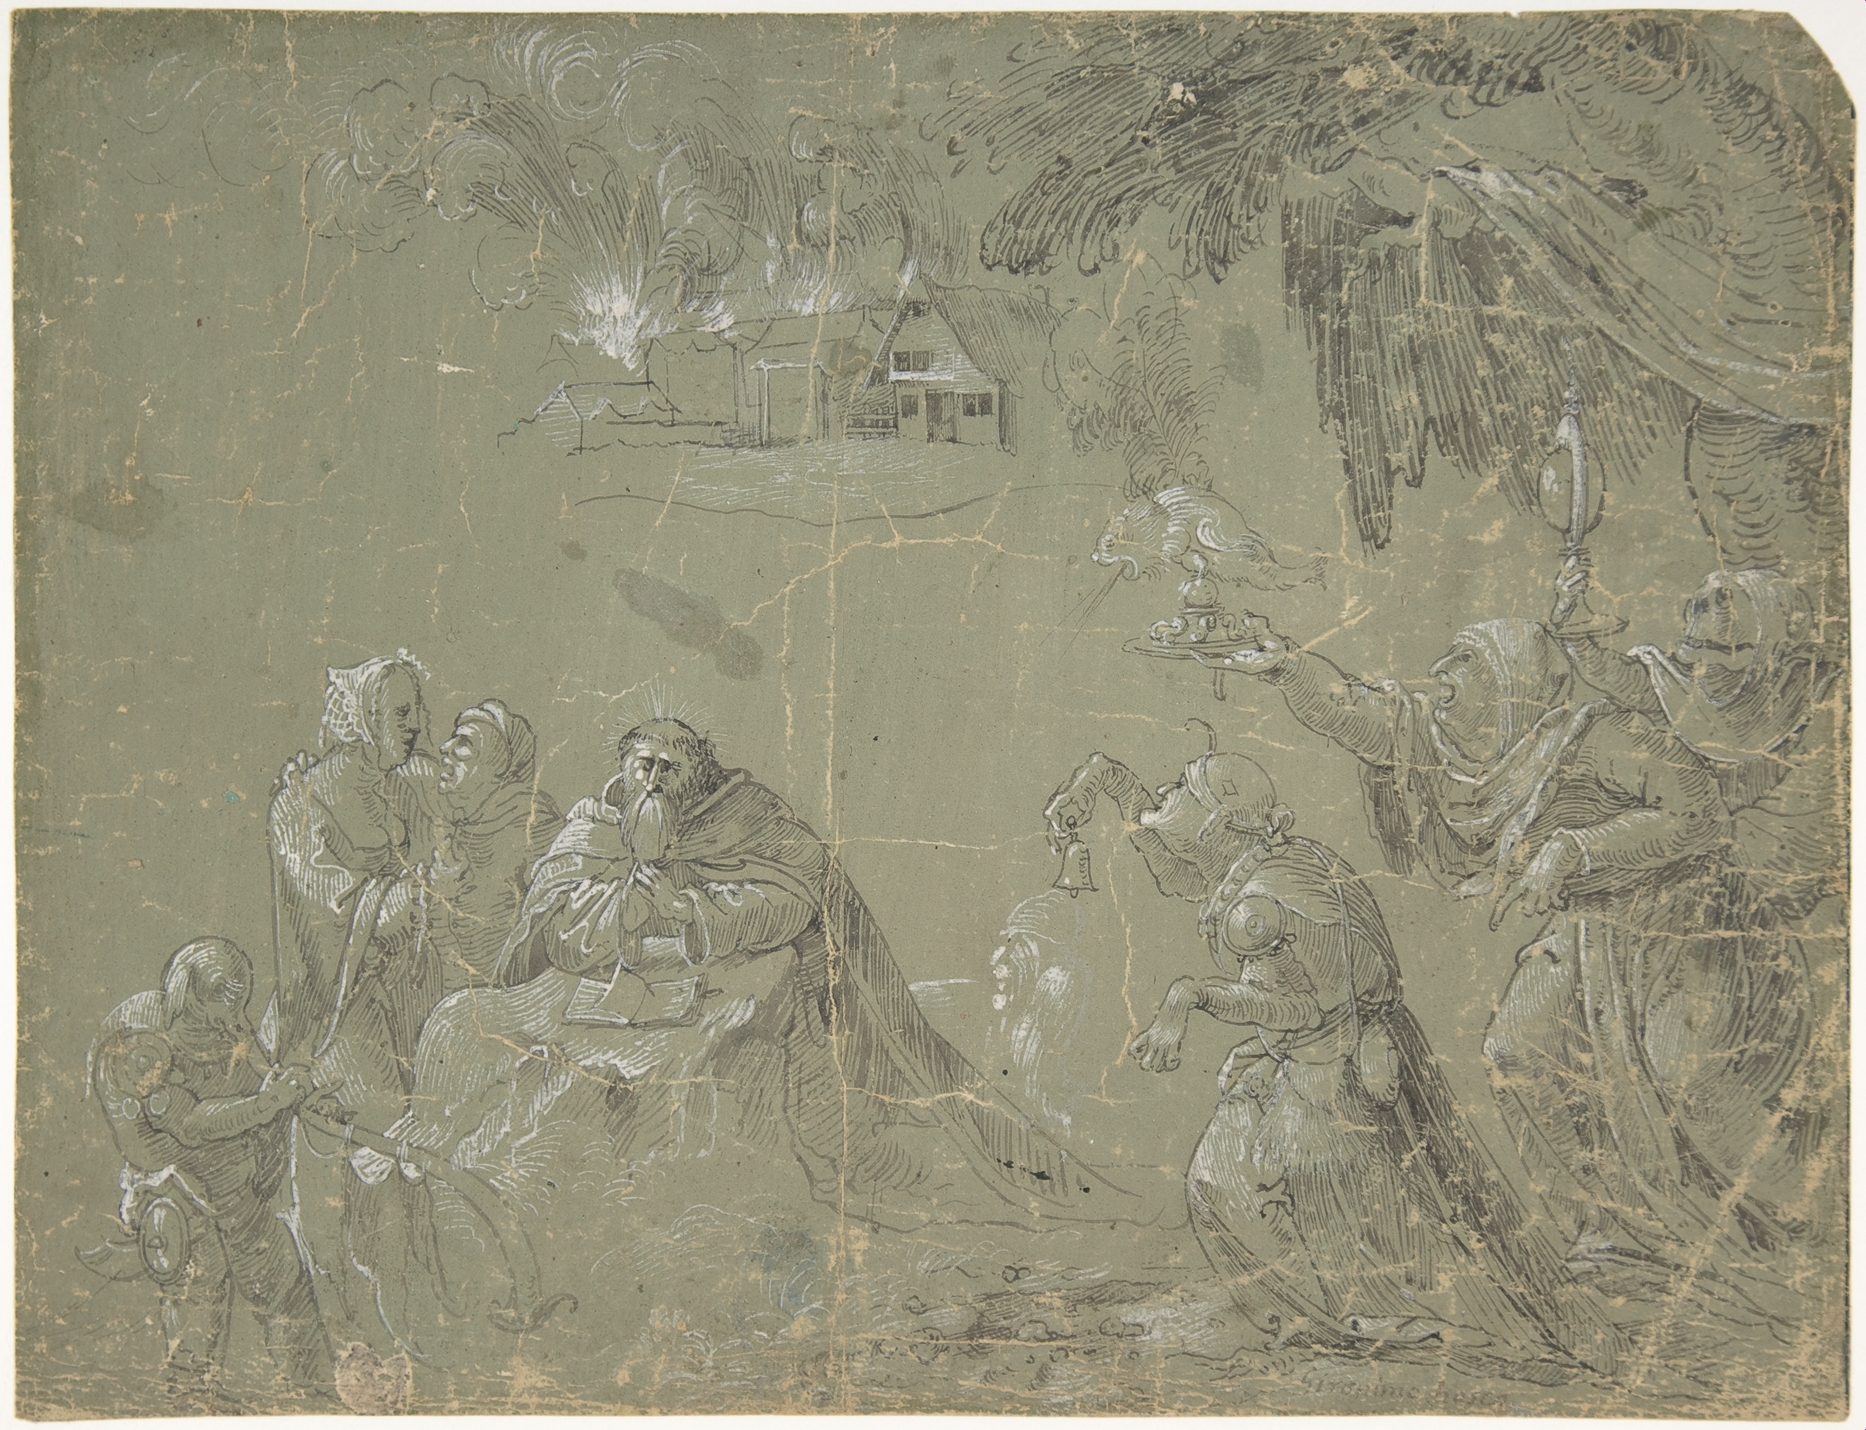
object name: drawing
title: Temptation of St. Anthony (recto); Fantastic Landscape (verso)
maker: jan wellens de cock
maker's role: artist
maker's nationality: netherlandish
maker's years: 1480-1527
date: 1520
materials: gouache, ink, paper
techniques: brush, heightening, pen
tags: men,saint anthony,demons